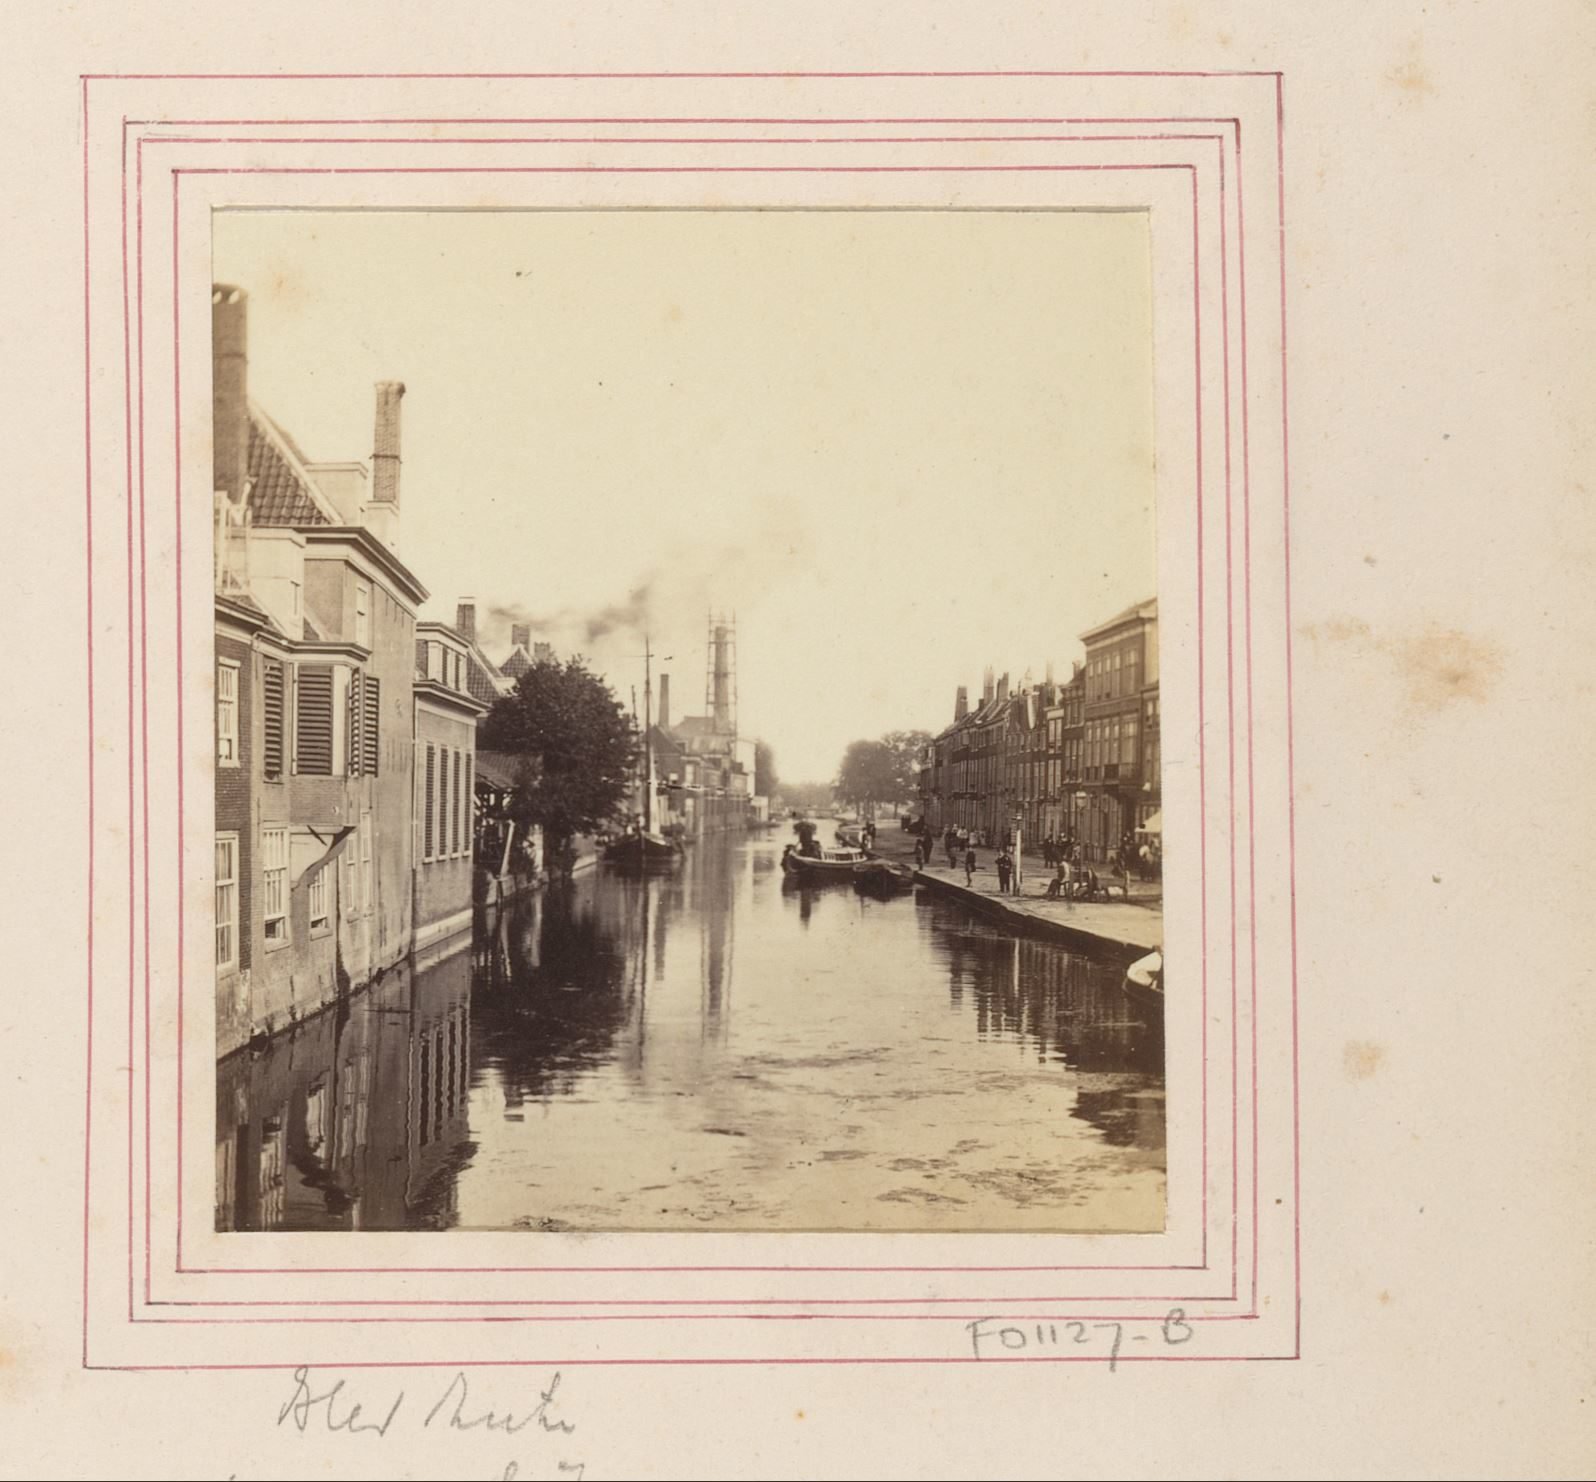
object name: photograph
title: Gezicht op Het Zieken in Den Haag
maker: andries jager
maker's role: publisher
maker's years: 1825-1905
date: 1870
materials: photographic support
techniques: albumen print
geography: zieken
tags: canals, waters (in city)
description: Onderdeel van Album met foto's en litho's van bezienswaardigheden in Noord- en Zuid-Hollandse steden, schilderijen en klederdrachten.